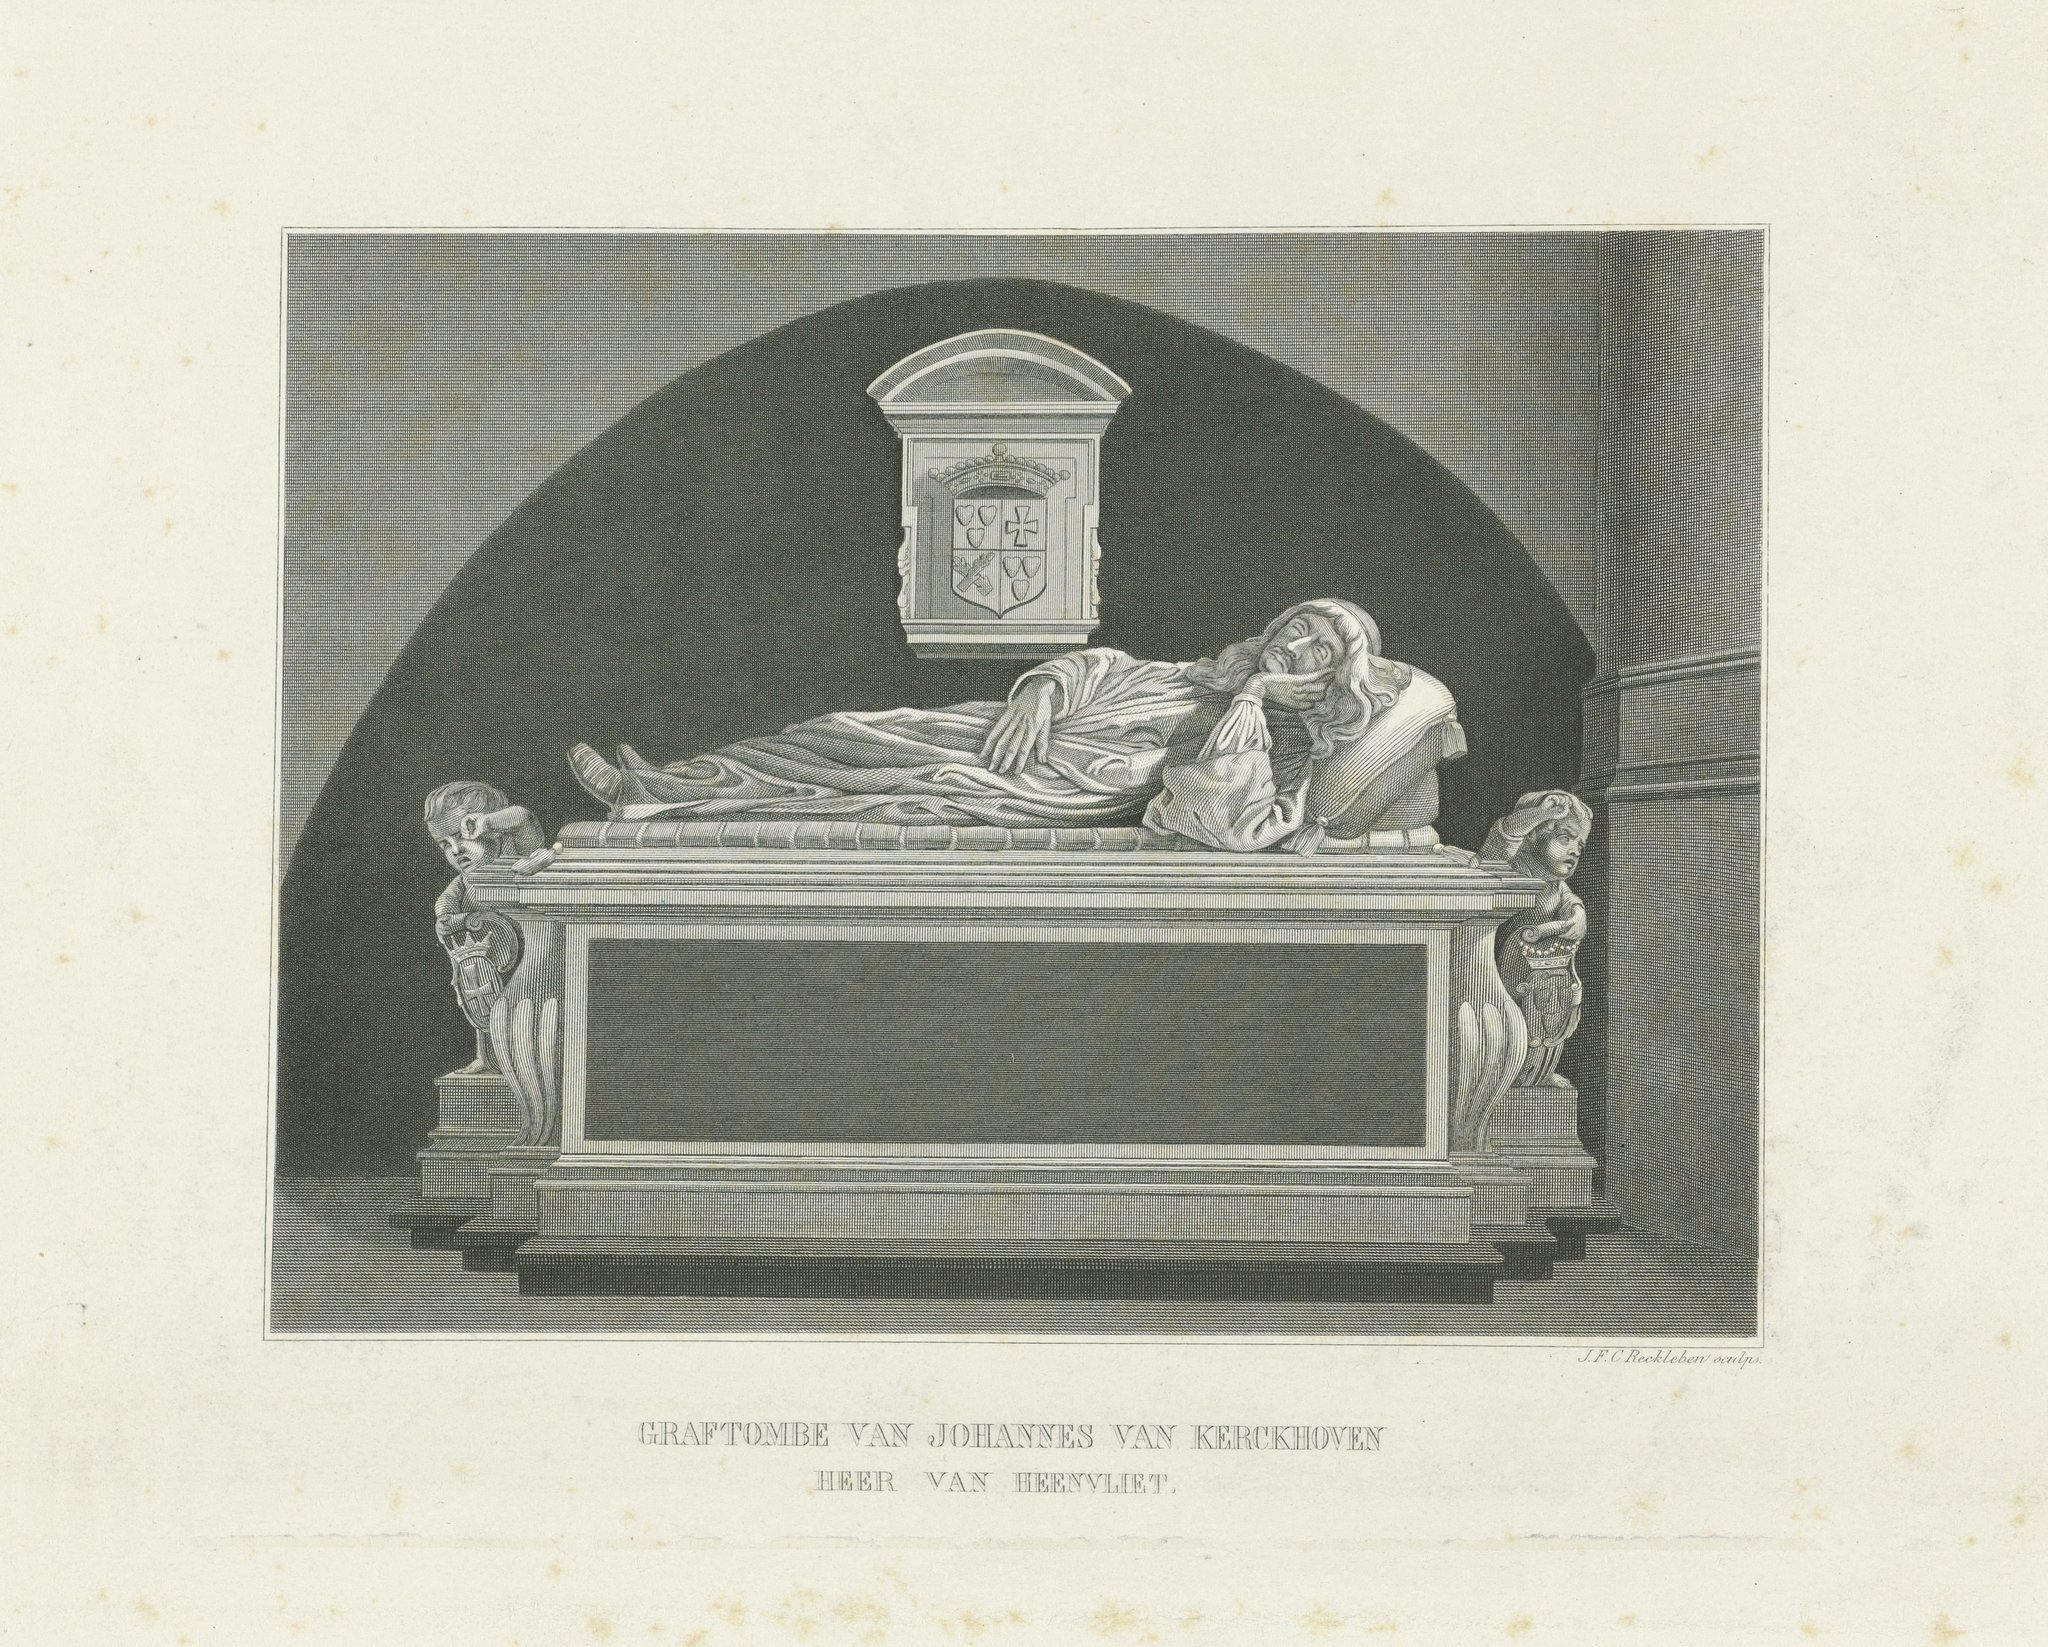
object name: print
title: Graftombe van Johannes Polyander van Kerkhoven (1594-1660)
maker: jan frederik christiaan reckleben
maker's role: print maker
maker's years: 1819-1879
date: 1829-1879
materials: paper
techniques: engraving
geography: amsterdam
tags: johannes polyander van kerkhoven (1594-1660)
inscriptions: inscription: Lugt 2228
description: Graftombe in de Pieterskerk te Leiden van Johannes Polyander van Kerkhoven (1594-1660), opgericht door zijn familie en vervaardigd door Rombout Verhulst. Hij was een zoon van predikant en hoogleraar theologie Johannes Polyander van Kerkhoven (1568-1646).